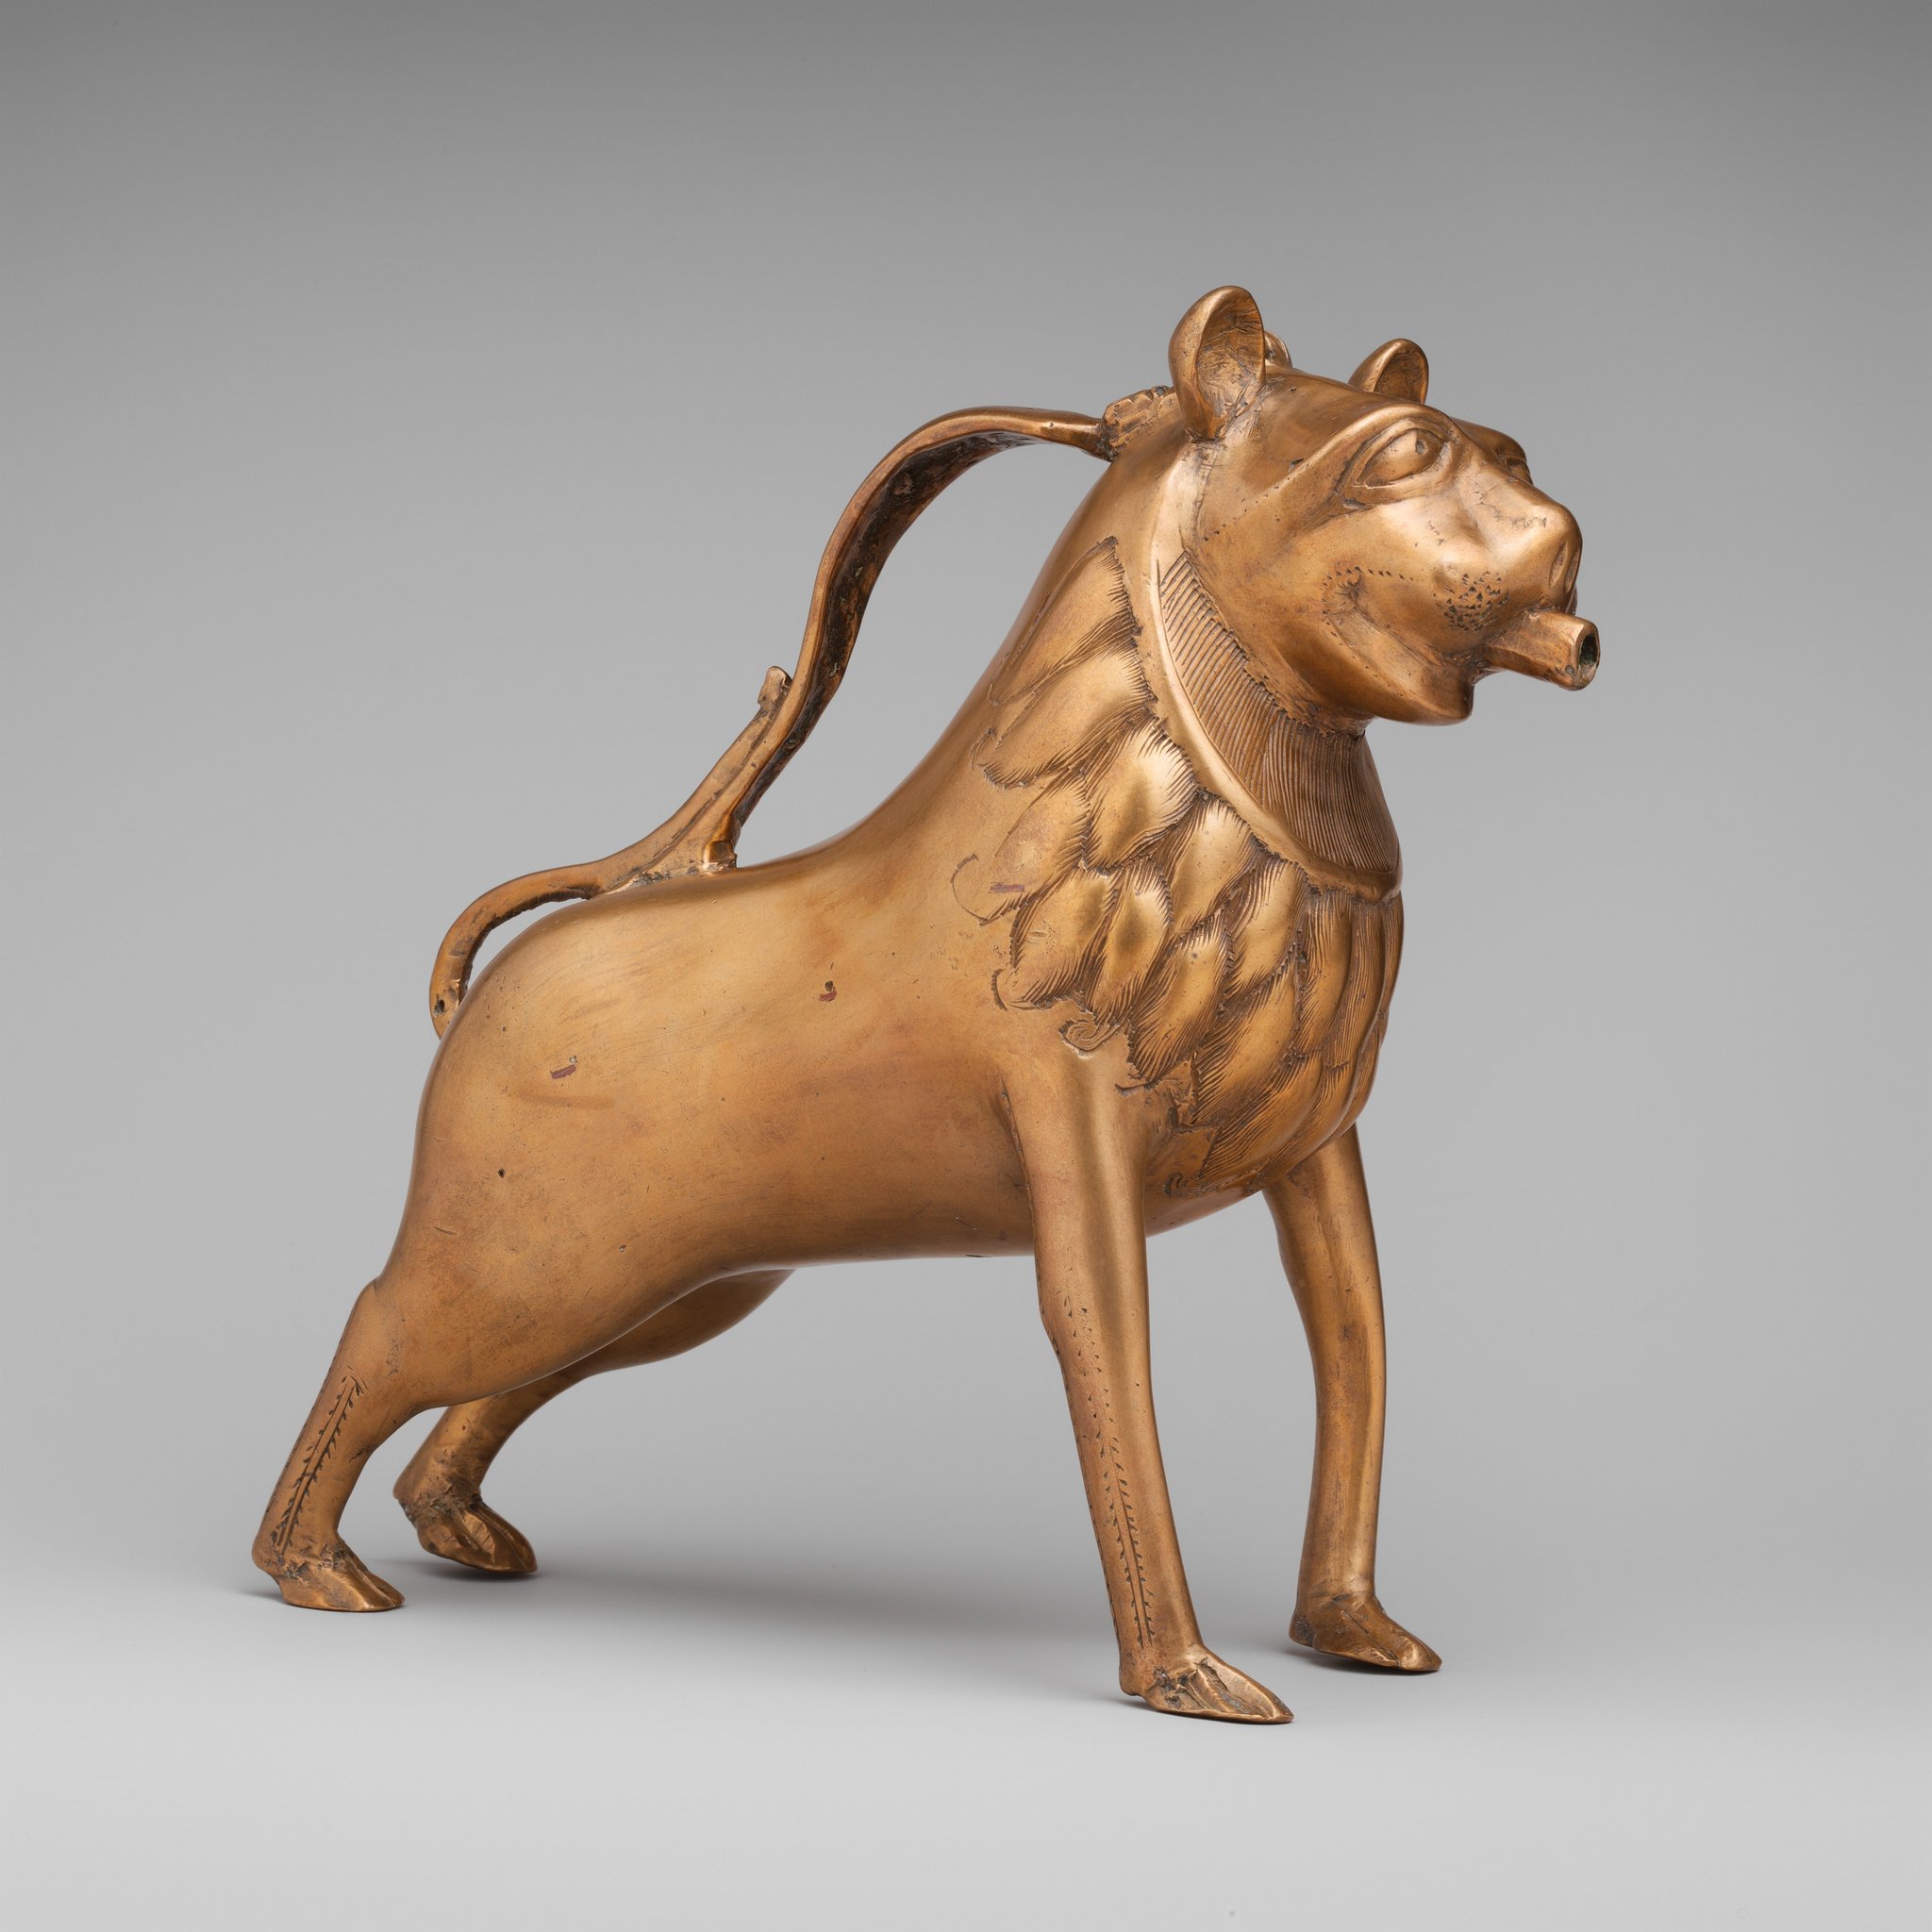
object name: aquamanile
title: Aquamanile in the Form of a Lion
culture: german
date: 1267-1333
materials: copper alloy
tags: lions